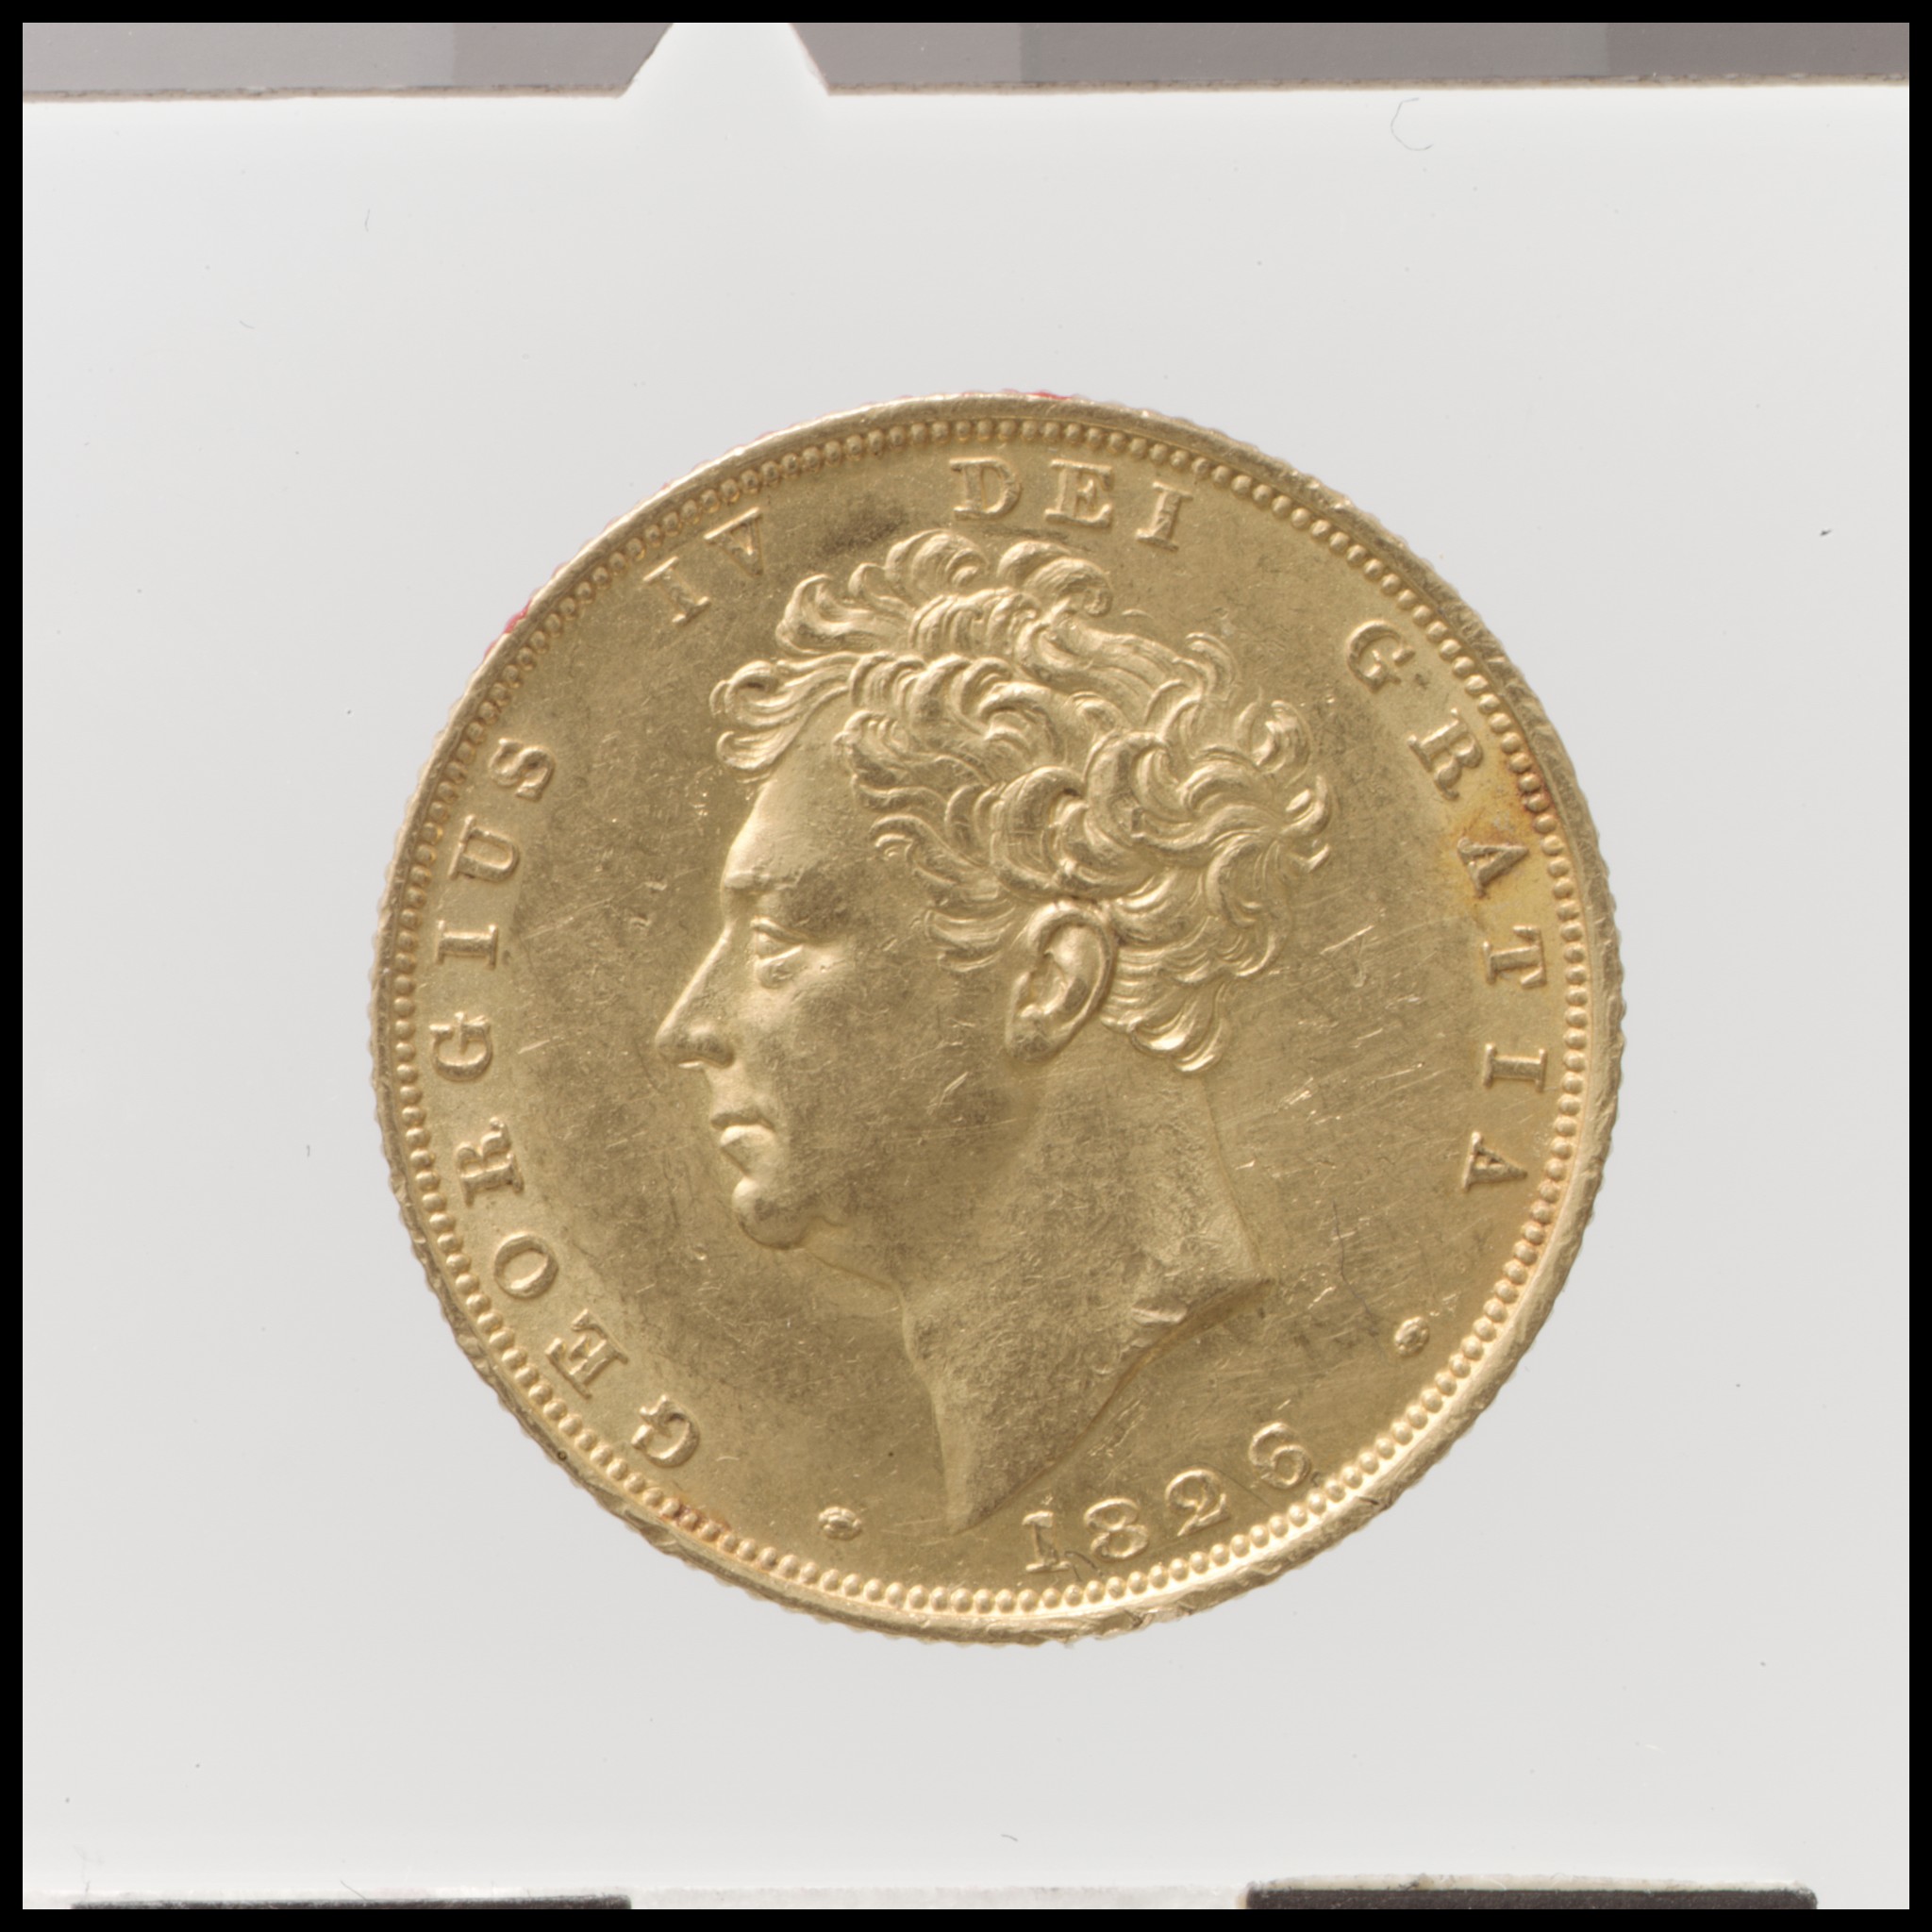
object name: sovereign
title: George IV sovereign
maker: william wyon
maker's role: artist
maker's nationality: british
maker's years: 1795-1851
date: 1826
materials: gold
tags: kings,profiles,coat of arms